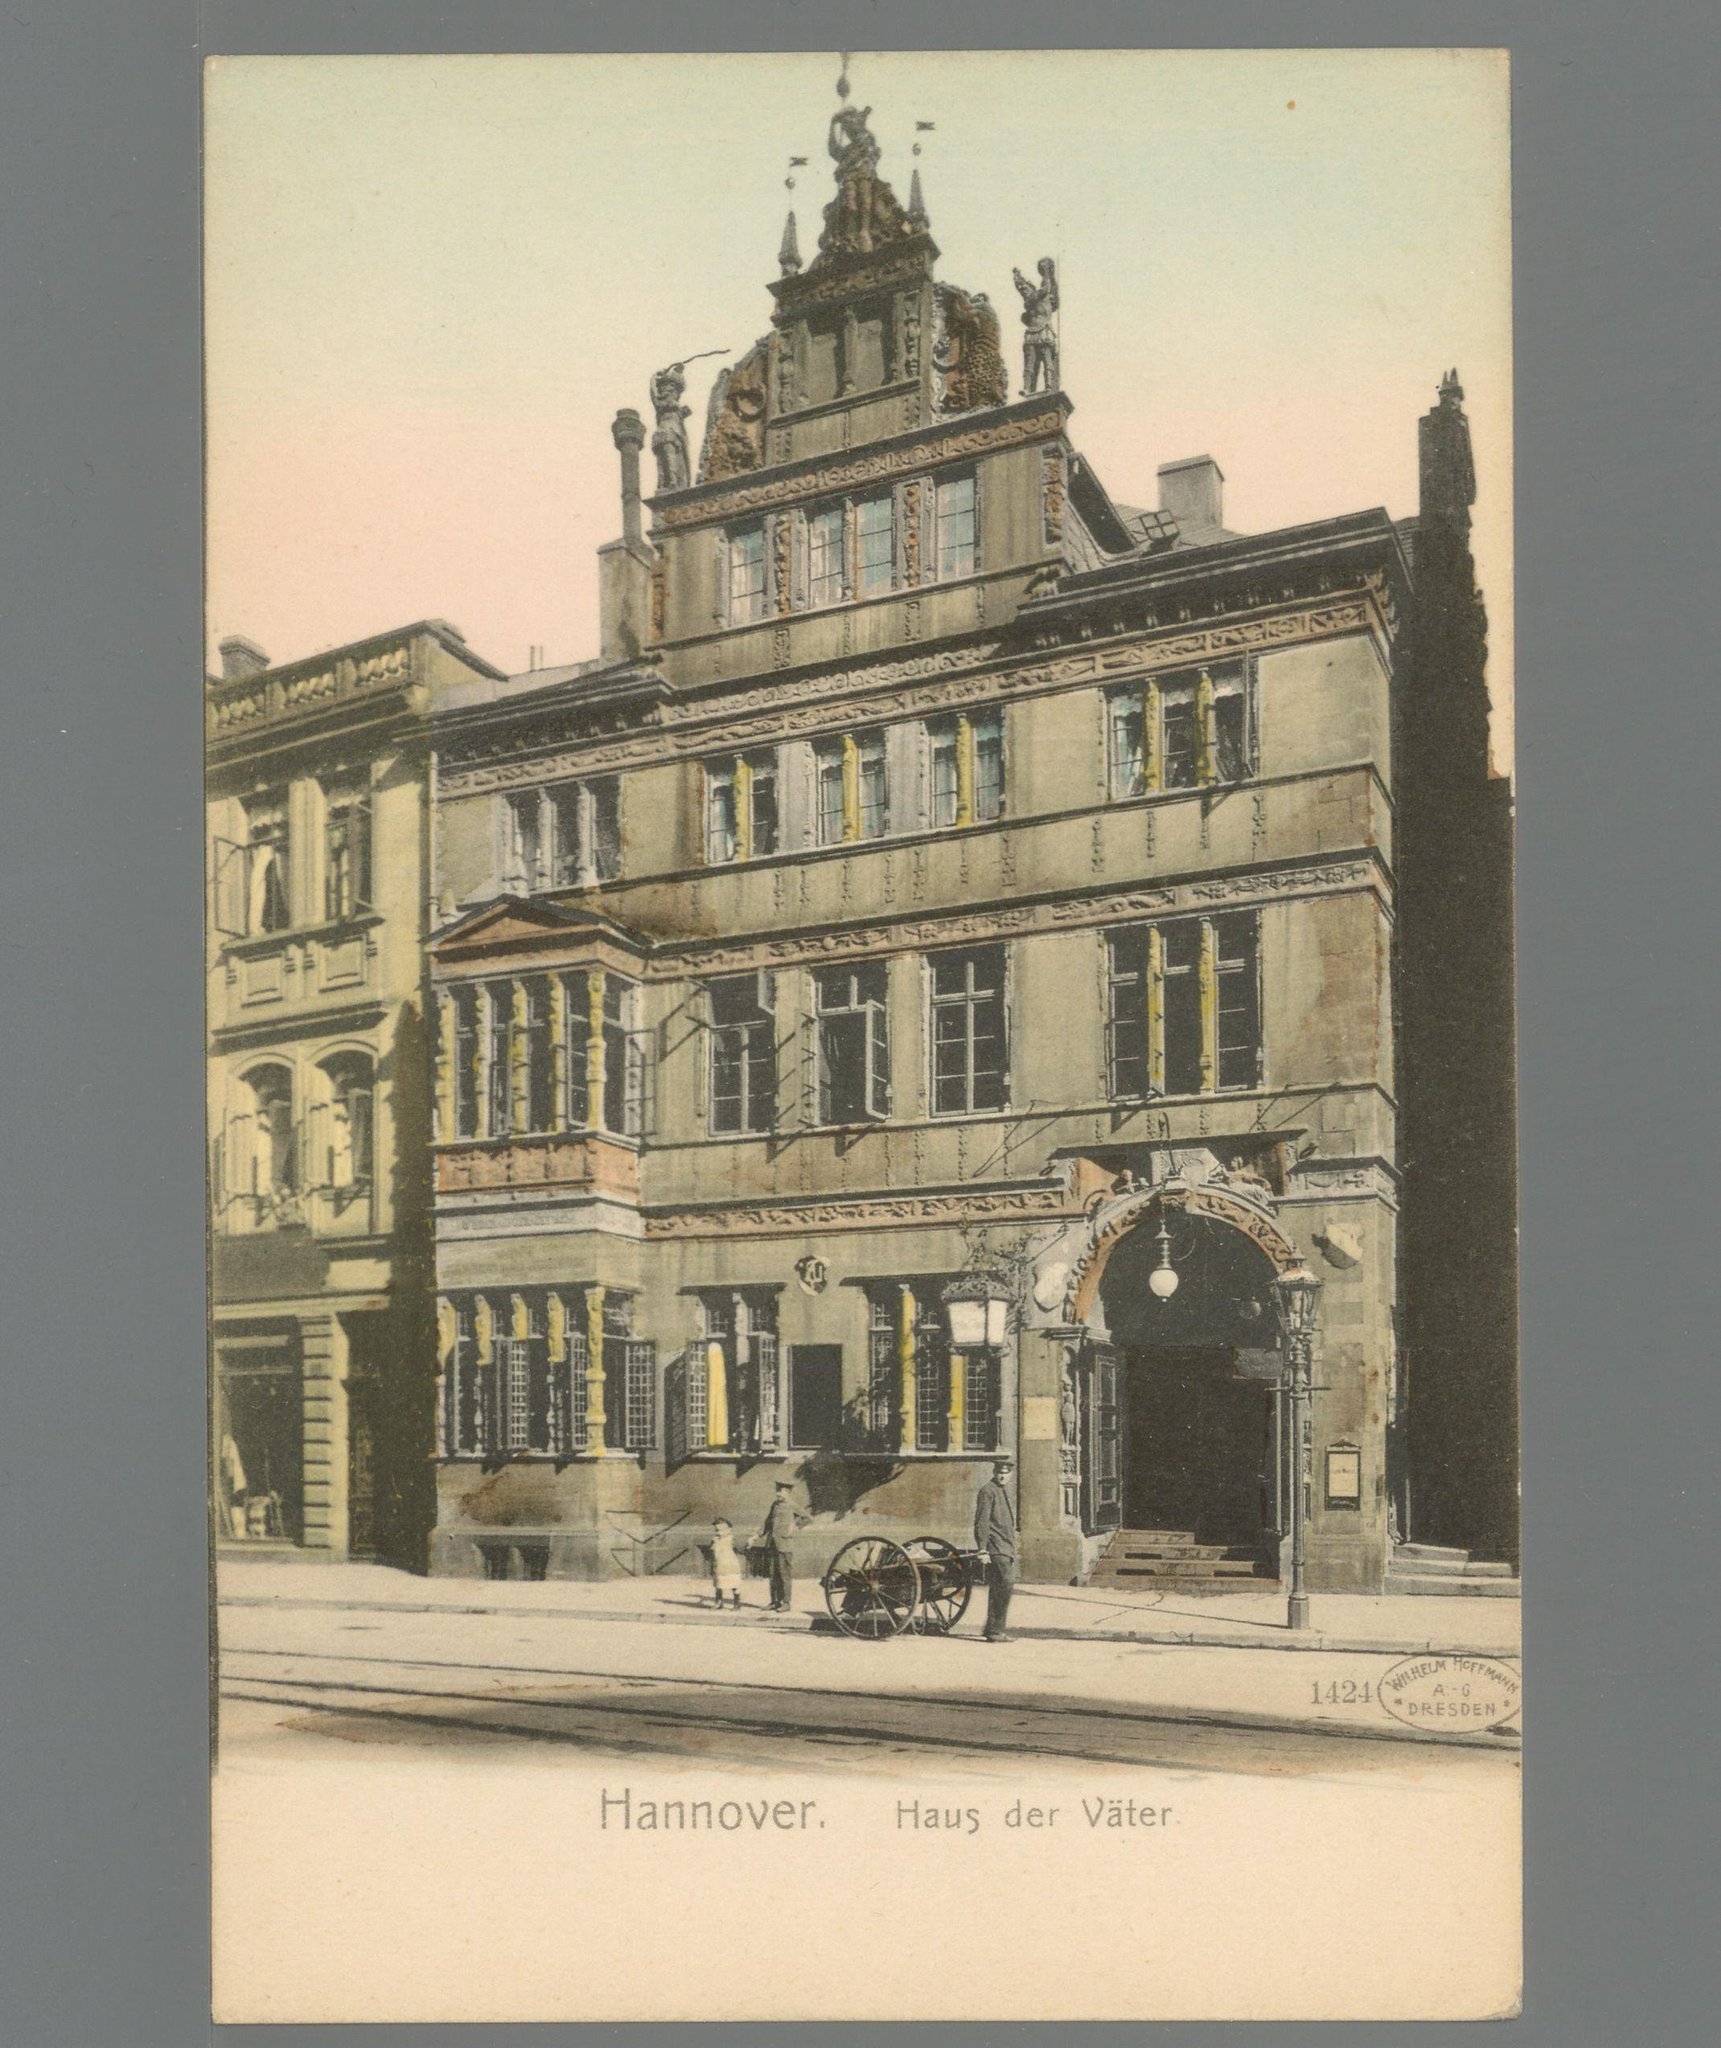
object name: ansichtkaart, prentbriefkaart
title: Hannover. Haus der Väter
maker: Anonymous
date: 1897-1905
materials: cardboard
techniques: photograph, lithograph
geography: dresden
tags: façade (of house or building)